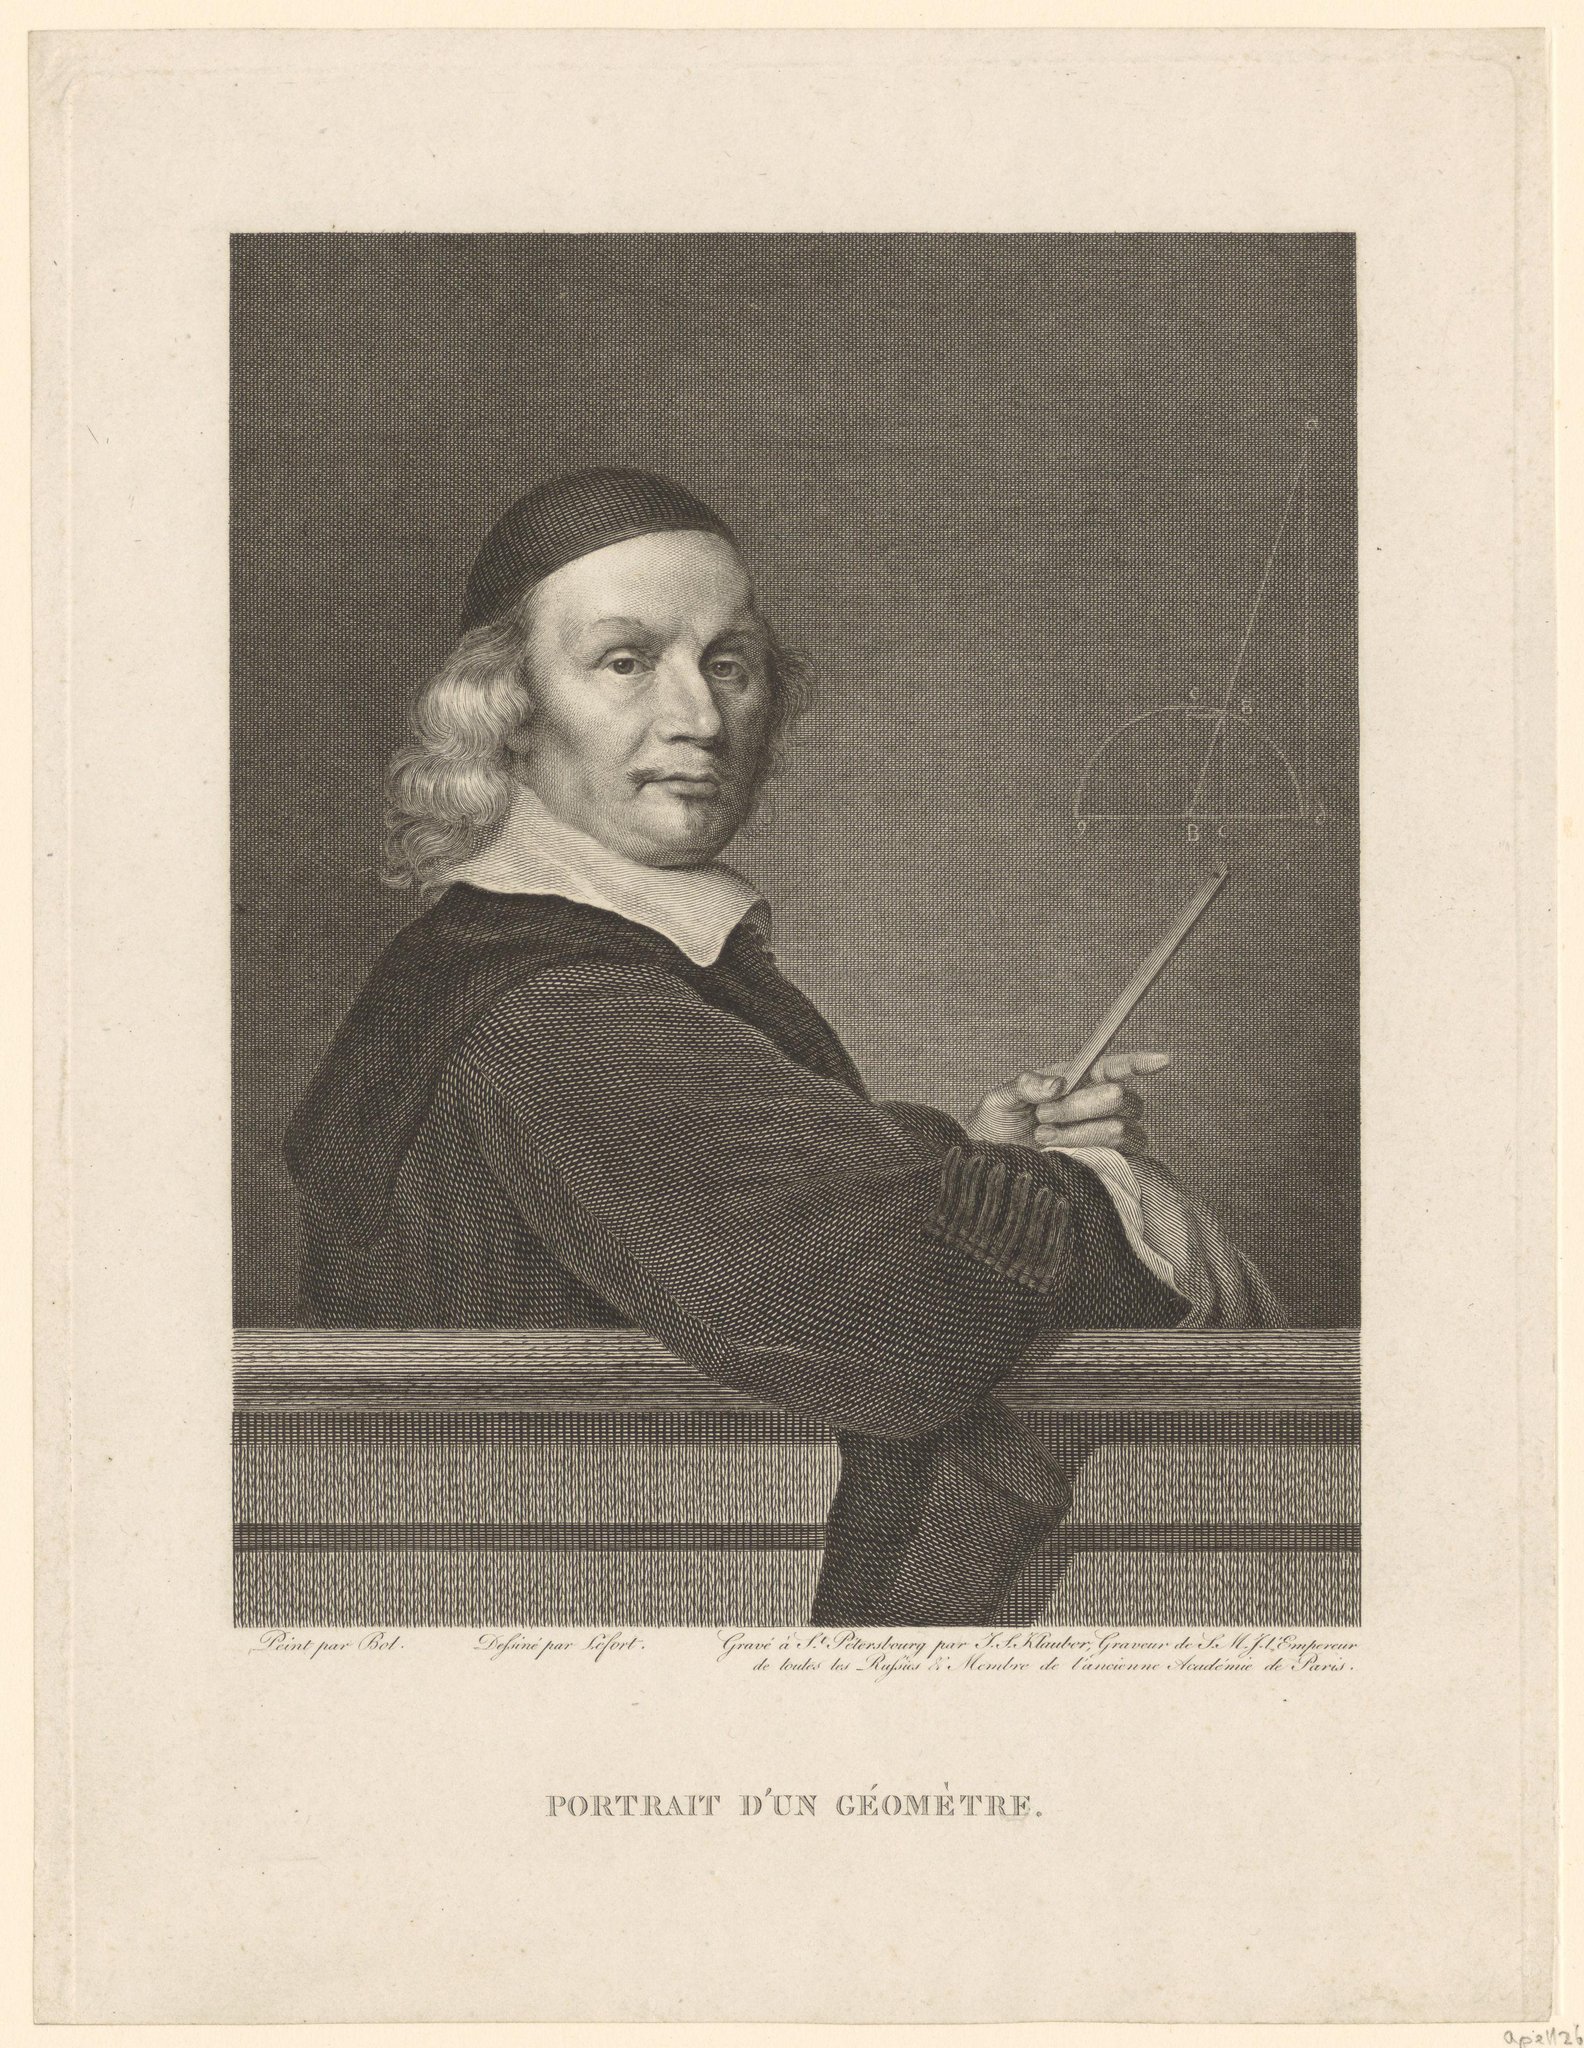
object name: print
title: Het Franse Museum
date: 1800-1809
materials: paper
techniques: engraving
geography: sint-petersburg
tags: anonymous historical person portrayed, mathematics (+ portrait of scholar, scientist)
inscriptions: collector's mark: Lugt 2228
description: Deze prent is gebruikt in: Robillard-Péronville, Laurent, Piere, Croze-Magnan, Simon-Célestin. Le Musée français, recueil complet des tableaux, statues et bas-reliefs, que composent la collection nationale (...) Gravure. Parijs: Louis-Étienne Herhan, 1805, dl. 2, p. 249. De bundel van vier delen bevat tekst en reproducties naar belangrijke kunstwerken (schilderijen, sculpturen en gravures) uit de nationale musea (veelal uit het Louvre) en is uitgegeven tussen 1800 en 1809. De eerste twee delen hebben tekst geschreven door Croze-Magnan, de laatste twee delen zijn geschreven door Eméric-David en Visconti. De serie is later opnieuw uitgegeven onder de titel 'Musée Royal, ou Recueil de gravures d'après les plus beaux tableaux, statues et bas-reliefs de la collection royale'. Het schilderij door Ferdinand Bol uit 1658 waarnaar deze prent is gemaakt bevindt zich in het Louvre, te Parijs, onder inv.nr. 1063.